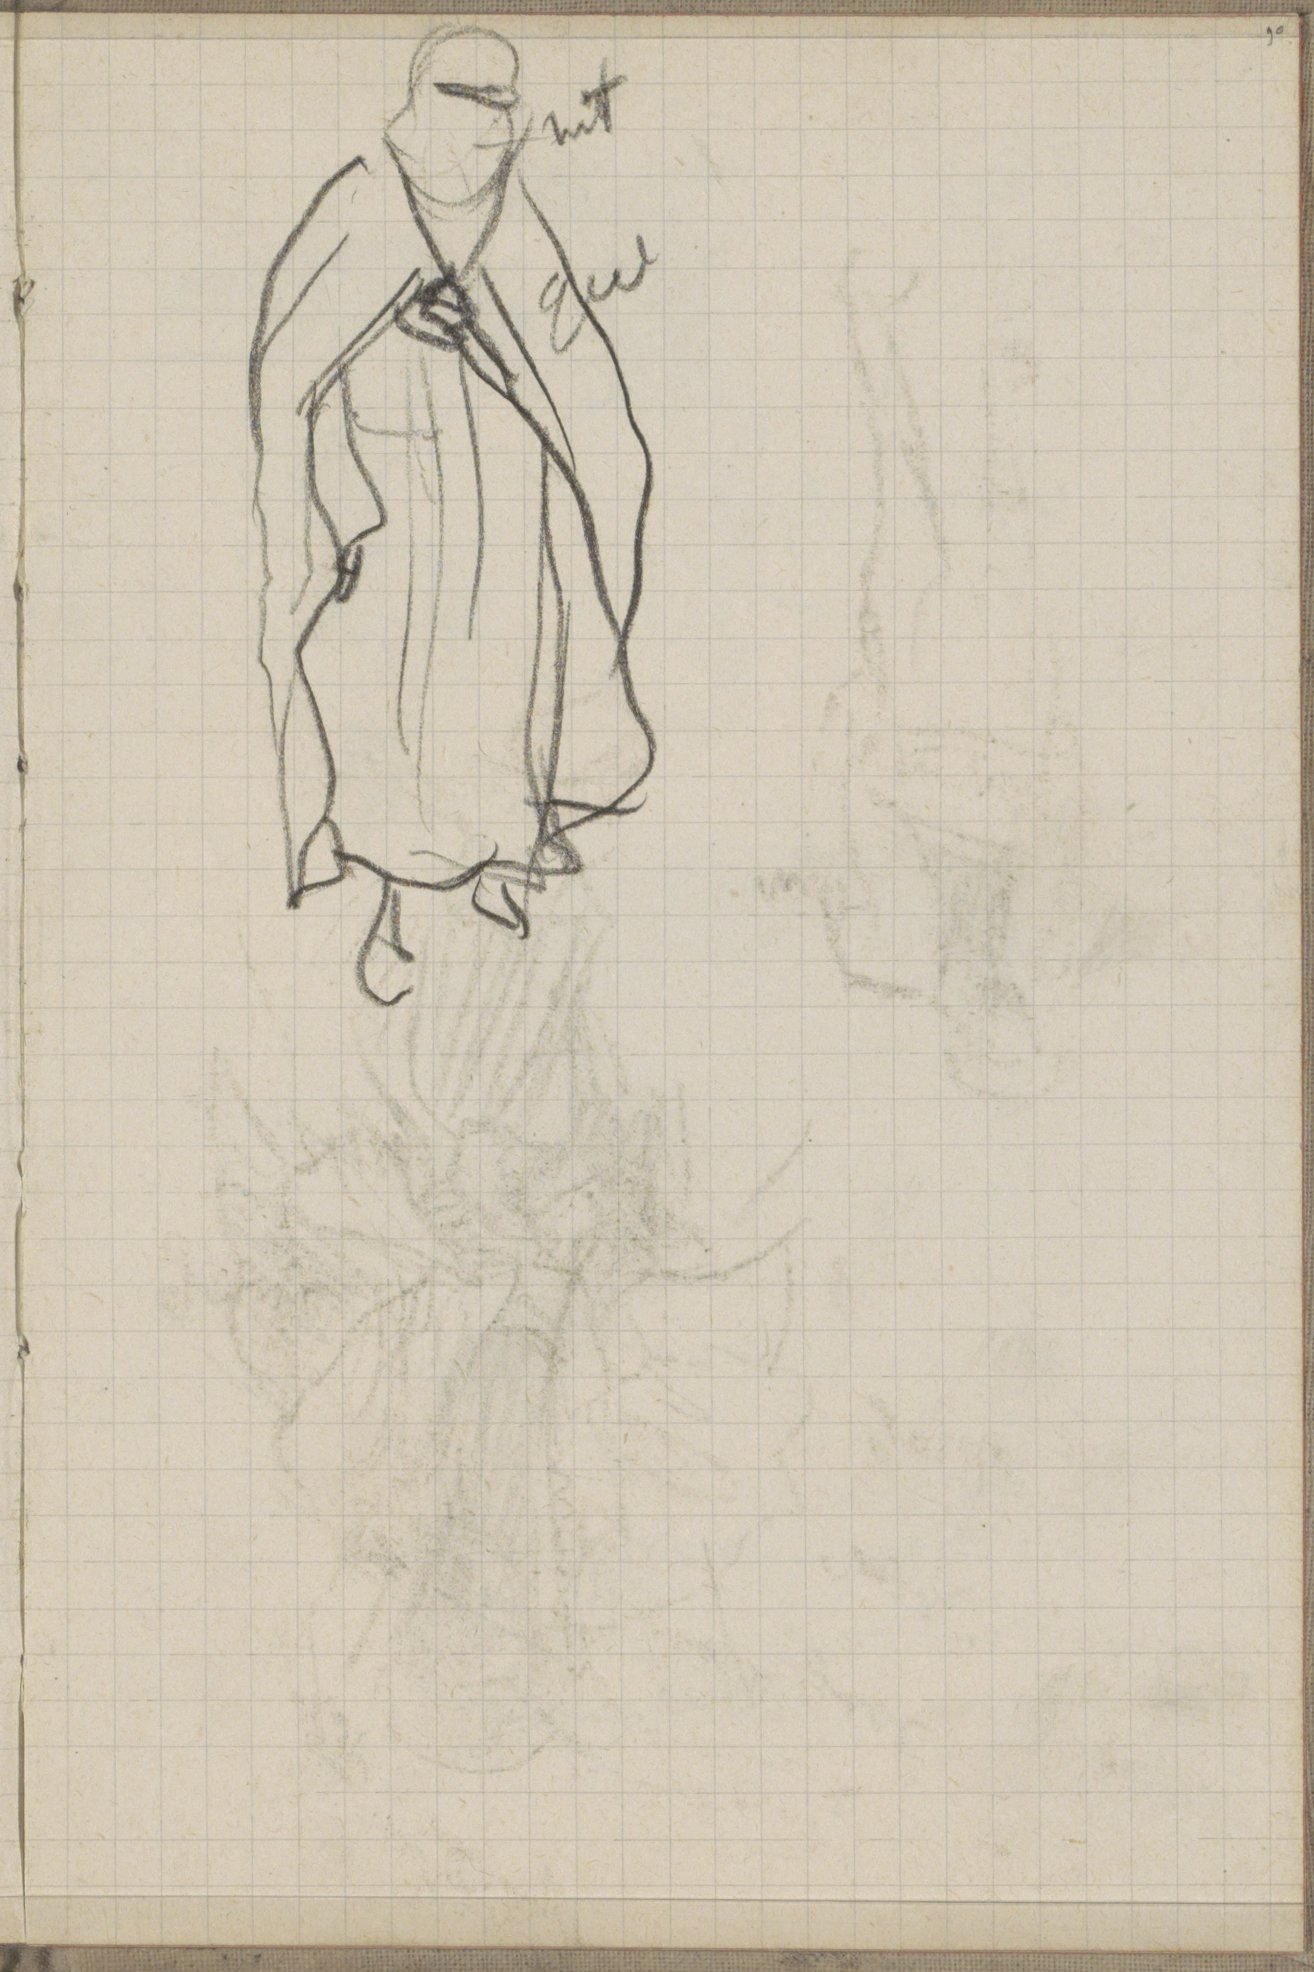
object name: sketchbook leaf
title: Figuur in oostere kleding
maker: marius bauer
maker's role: draughtsman, print maker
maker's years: 1867-1932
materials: chalk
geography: istanbul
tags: asiatic races and peoples, anatomy (non-medical)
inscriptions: kleurnotitie, handgeschreven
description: Van voren gezien. Pagina 90 uit een schetsboek met 51 bladen.